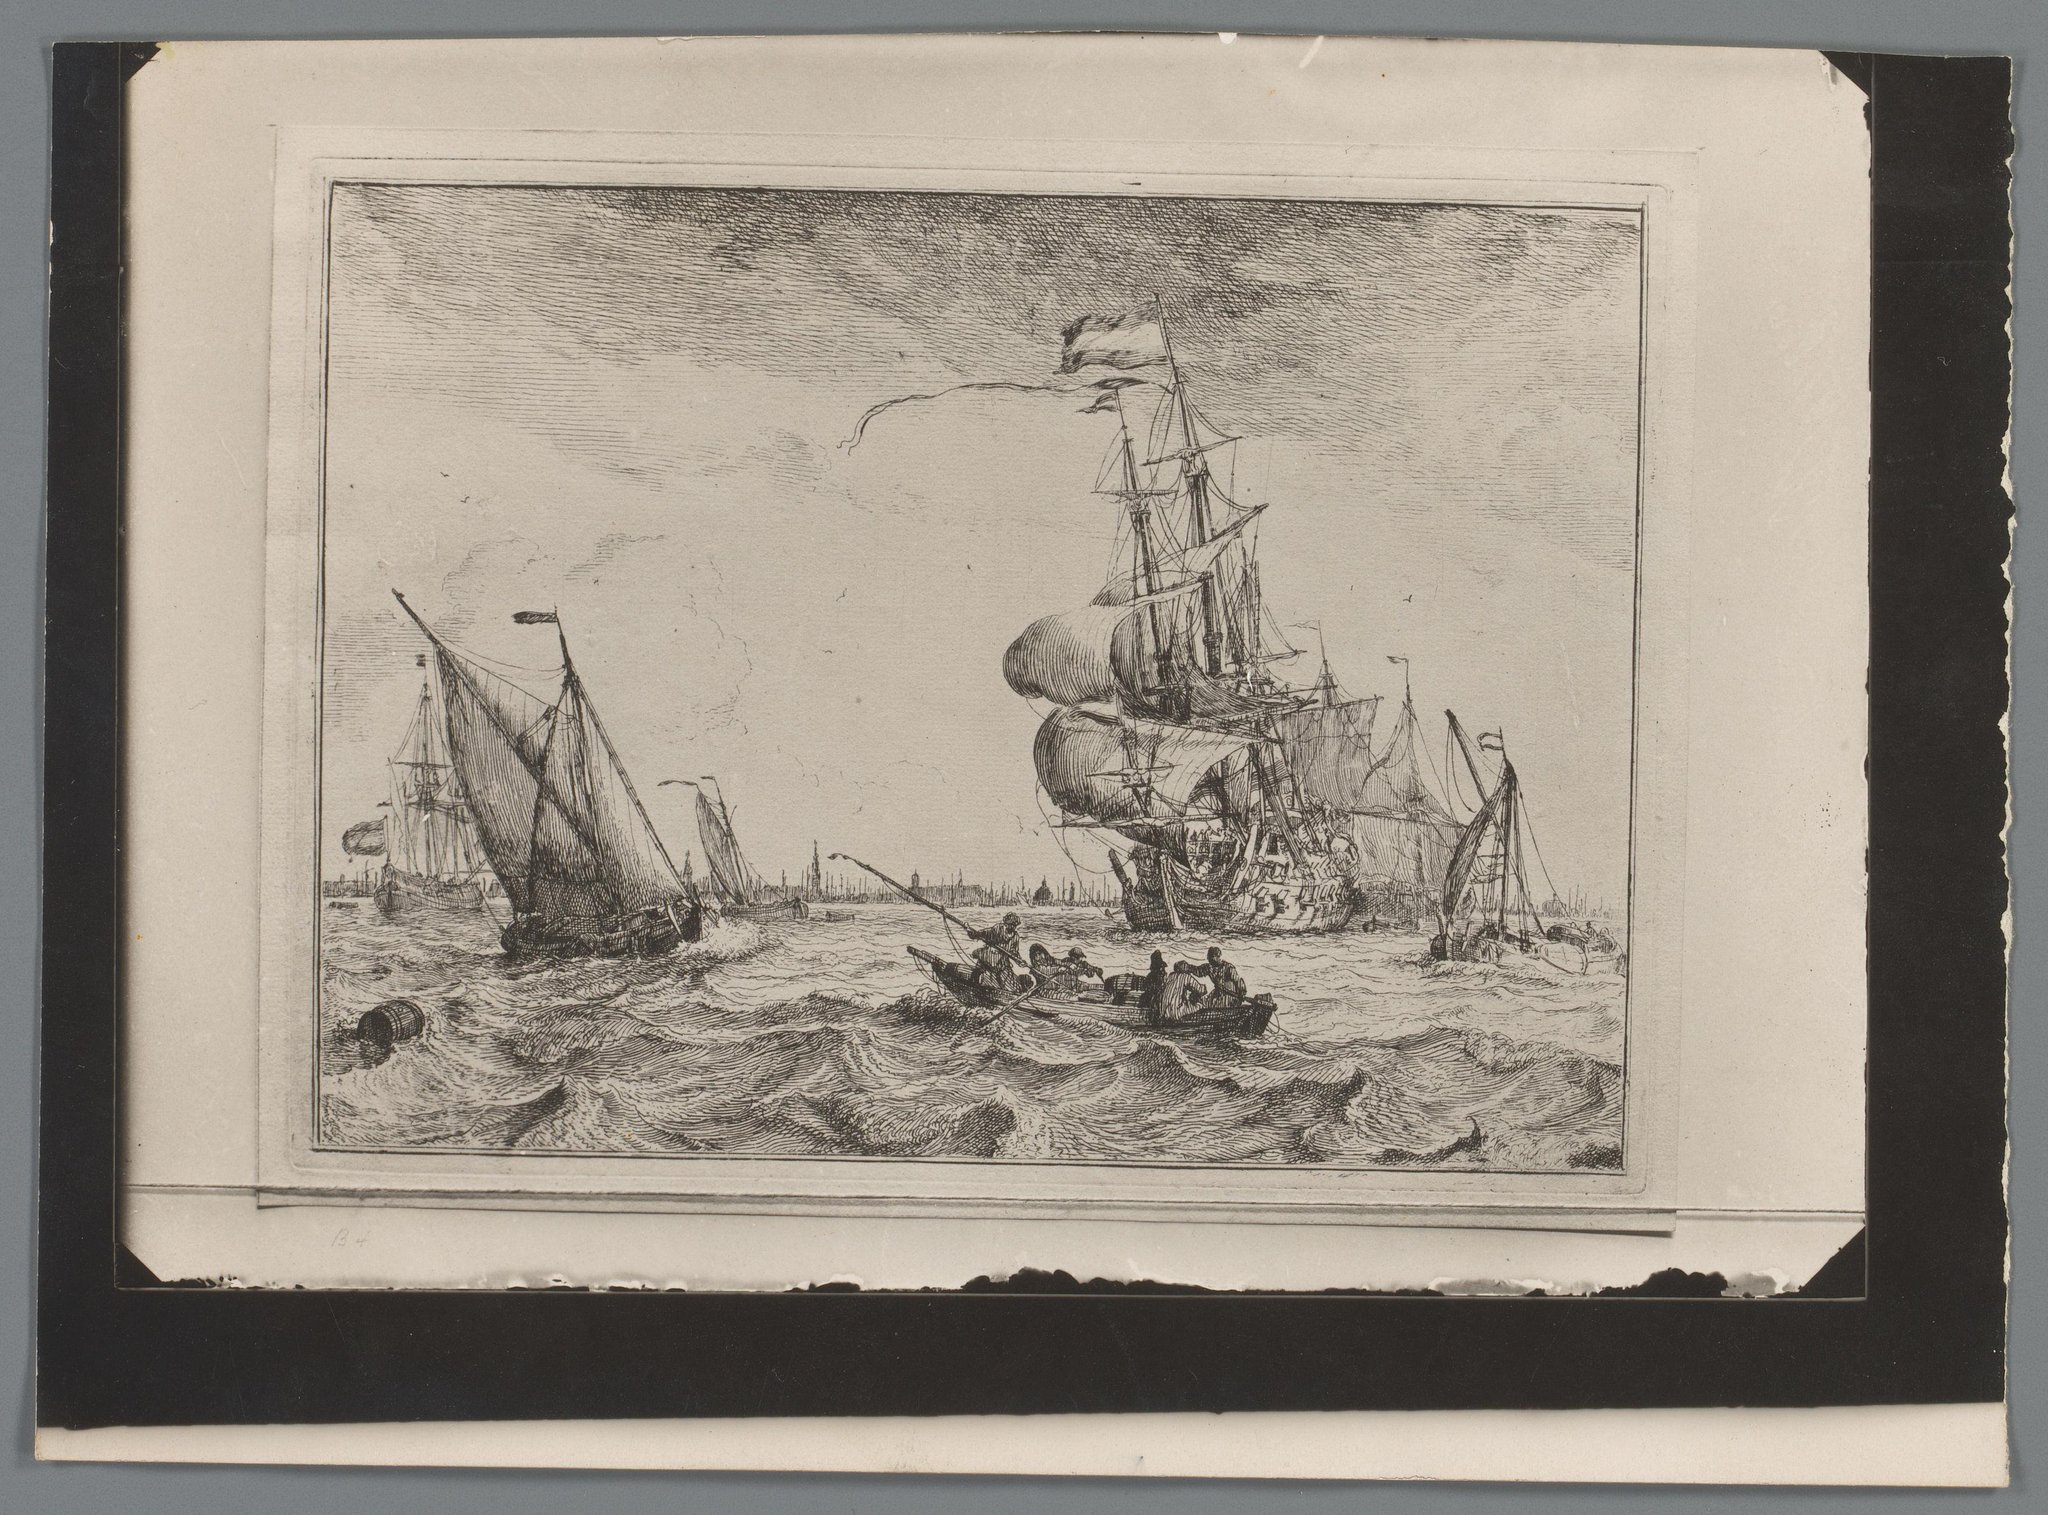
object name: reproduction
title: Fotoreproductie van prent van Gezicht op het IJ met roeiboot, door Ludolf Bakhuysen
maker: Anonymous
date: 1910-1990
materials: paper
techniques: gelatin silver print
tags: sailing-ship, sailing-boat, sea (seascape), rowing facing backward, pulling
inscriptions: inscription: ‘7440.34/ binnen 8 1/2 a/5’, number: ‘602a’